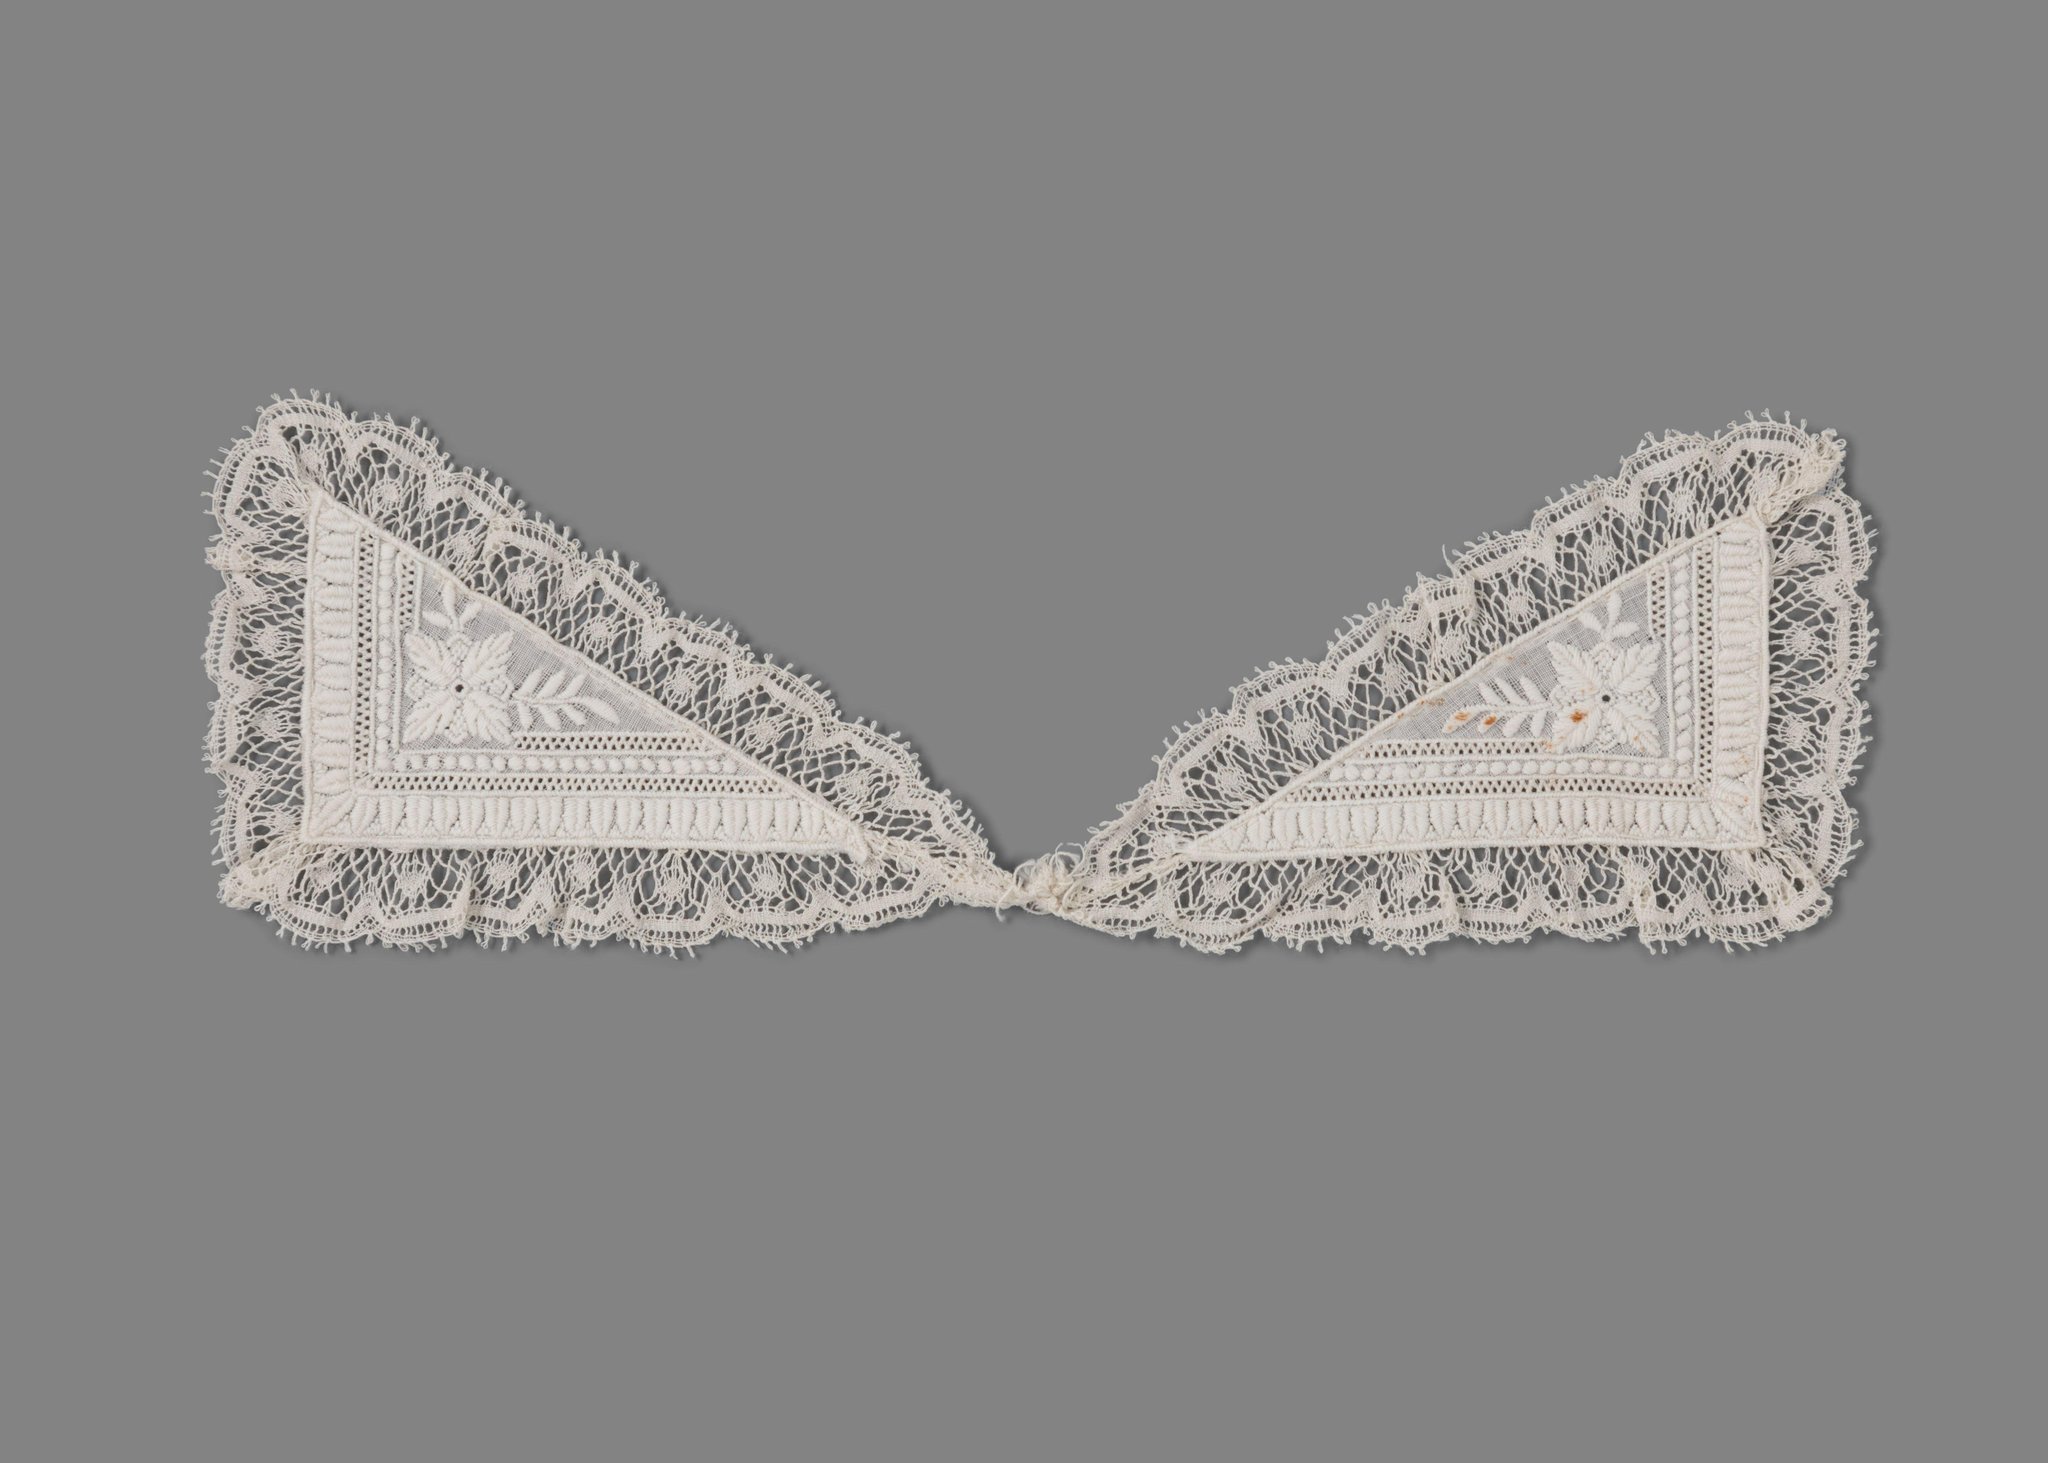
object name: womenswear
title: Twee aaneengenaaide driehoekige punten van batist van een omslagboord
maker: Anonymous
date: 1875-1900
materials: linen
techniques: embroidery, embroidered, lace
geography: western europe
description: Twee aaneengenaaide driehoekige punten van batist van een omslagboord met witwerk en een gerimpeld aangezette strook Valenciennes-kant. De decoratie bestaat uit verschillende randen met blad- en ajourwerk. Binnen de randen is een bloem met vier bladen aan kleine takken geborduurd.